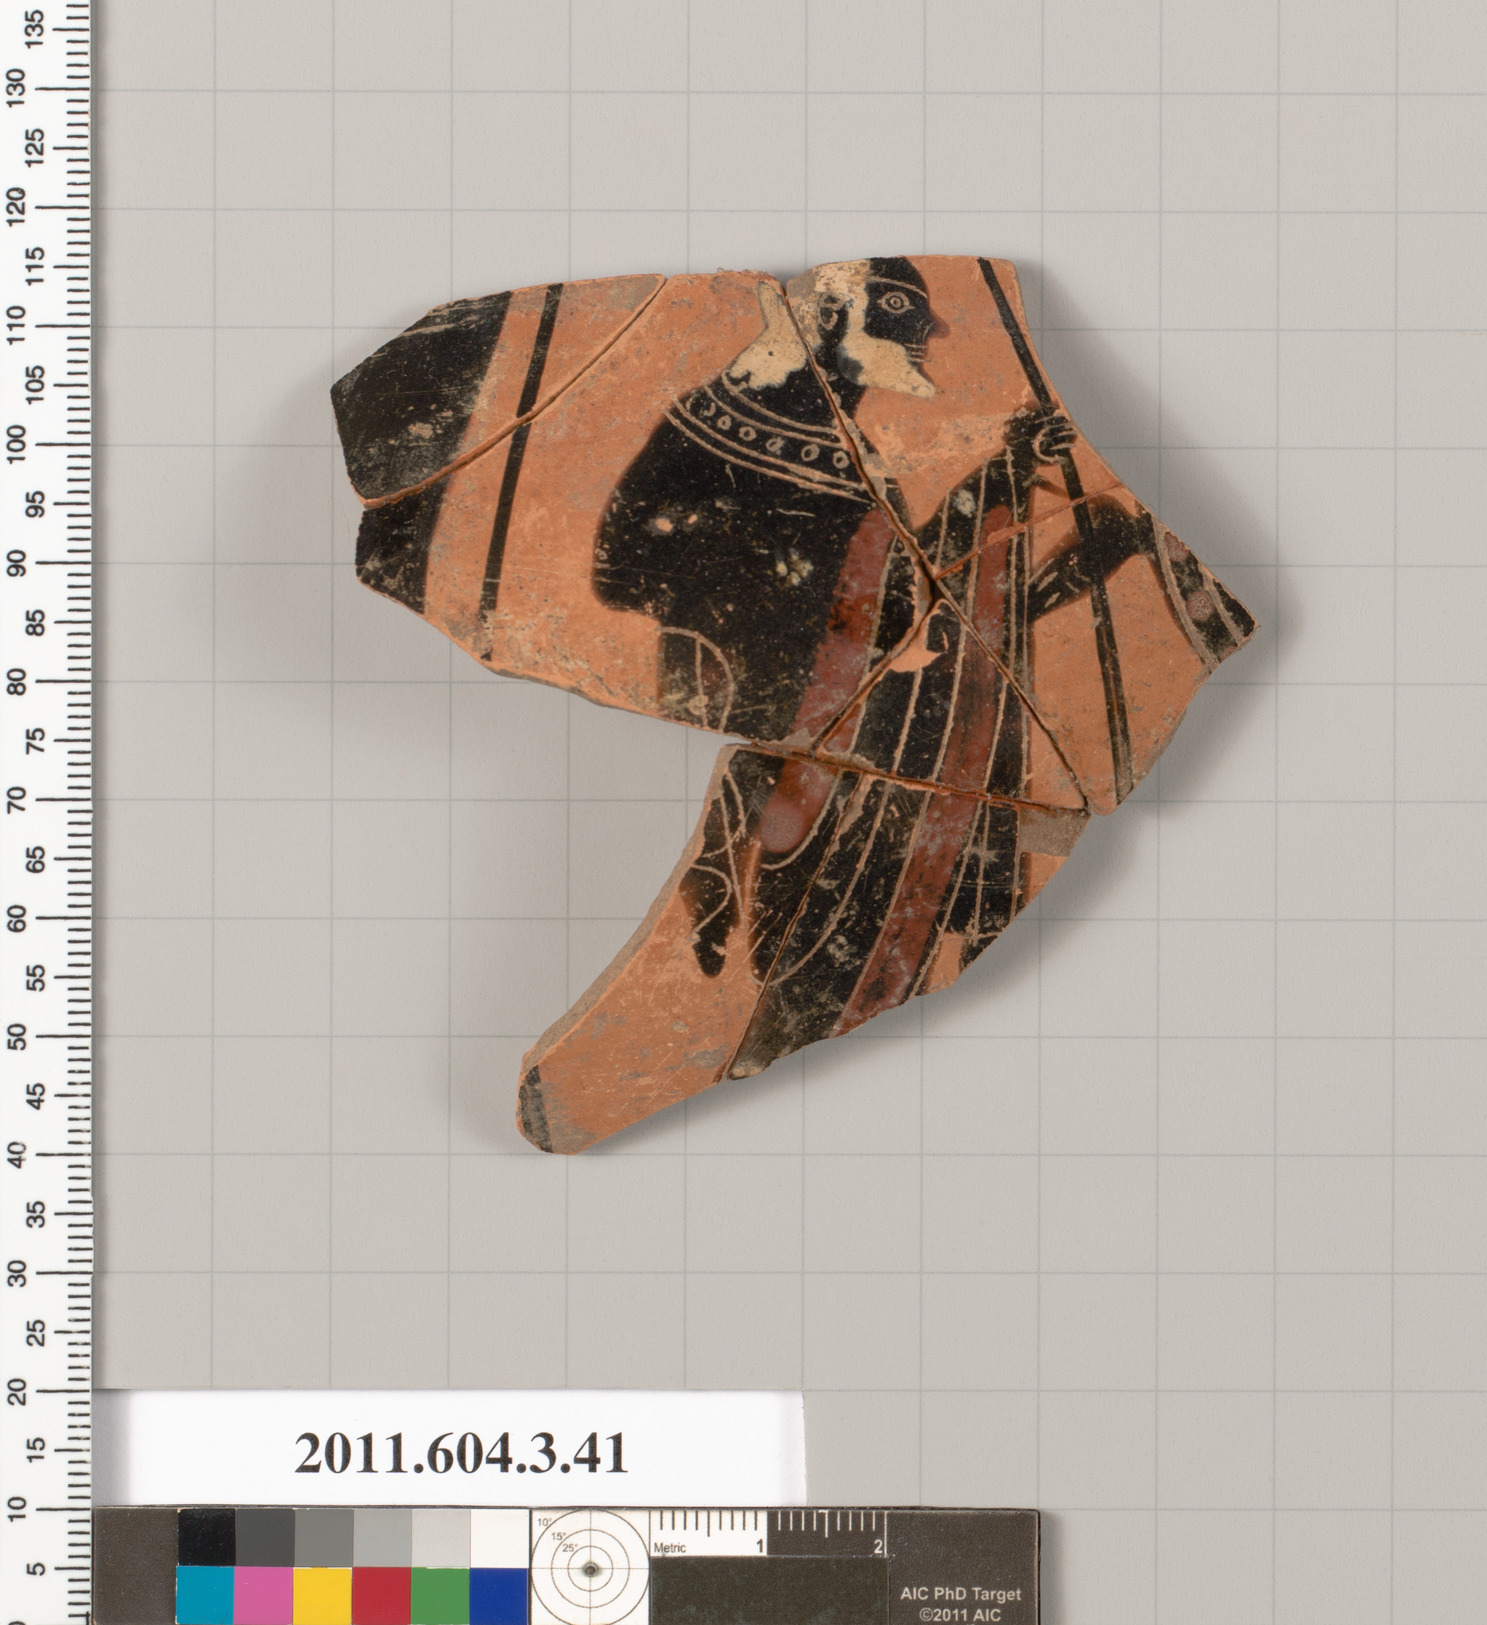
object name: amphora fragment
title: Terracotta fragment of an amphora (jar)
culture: greek, attic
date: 540-530 BCE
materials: terracotta